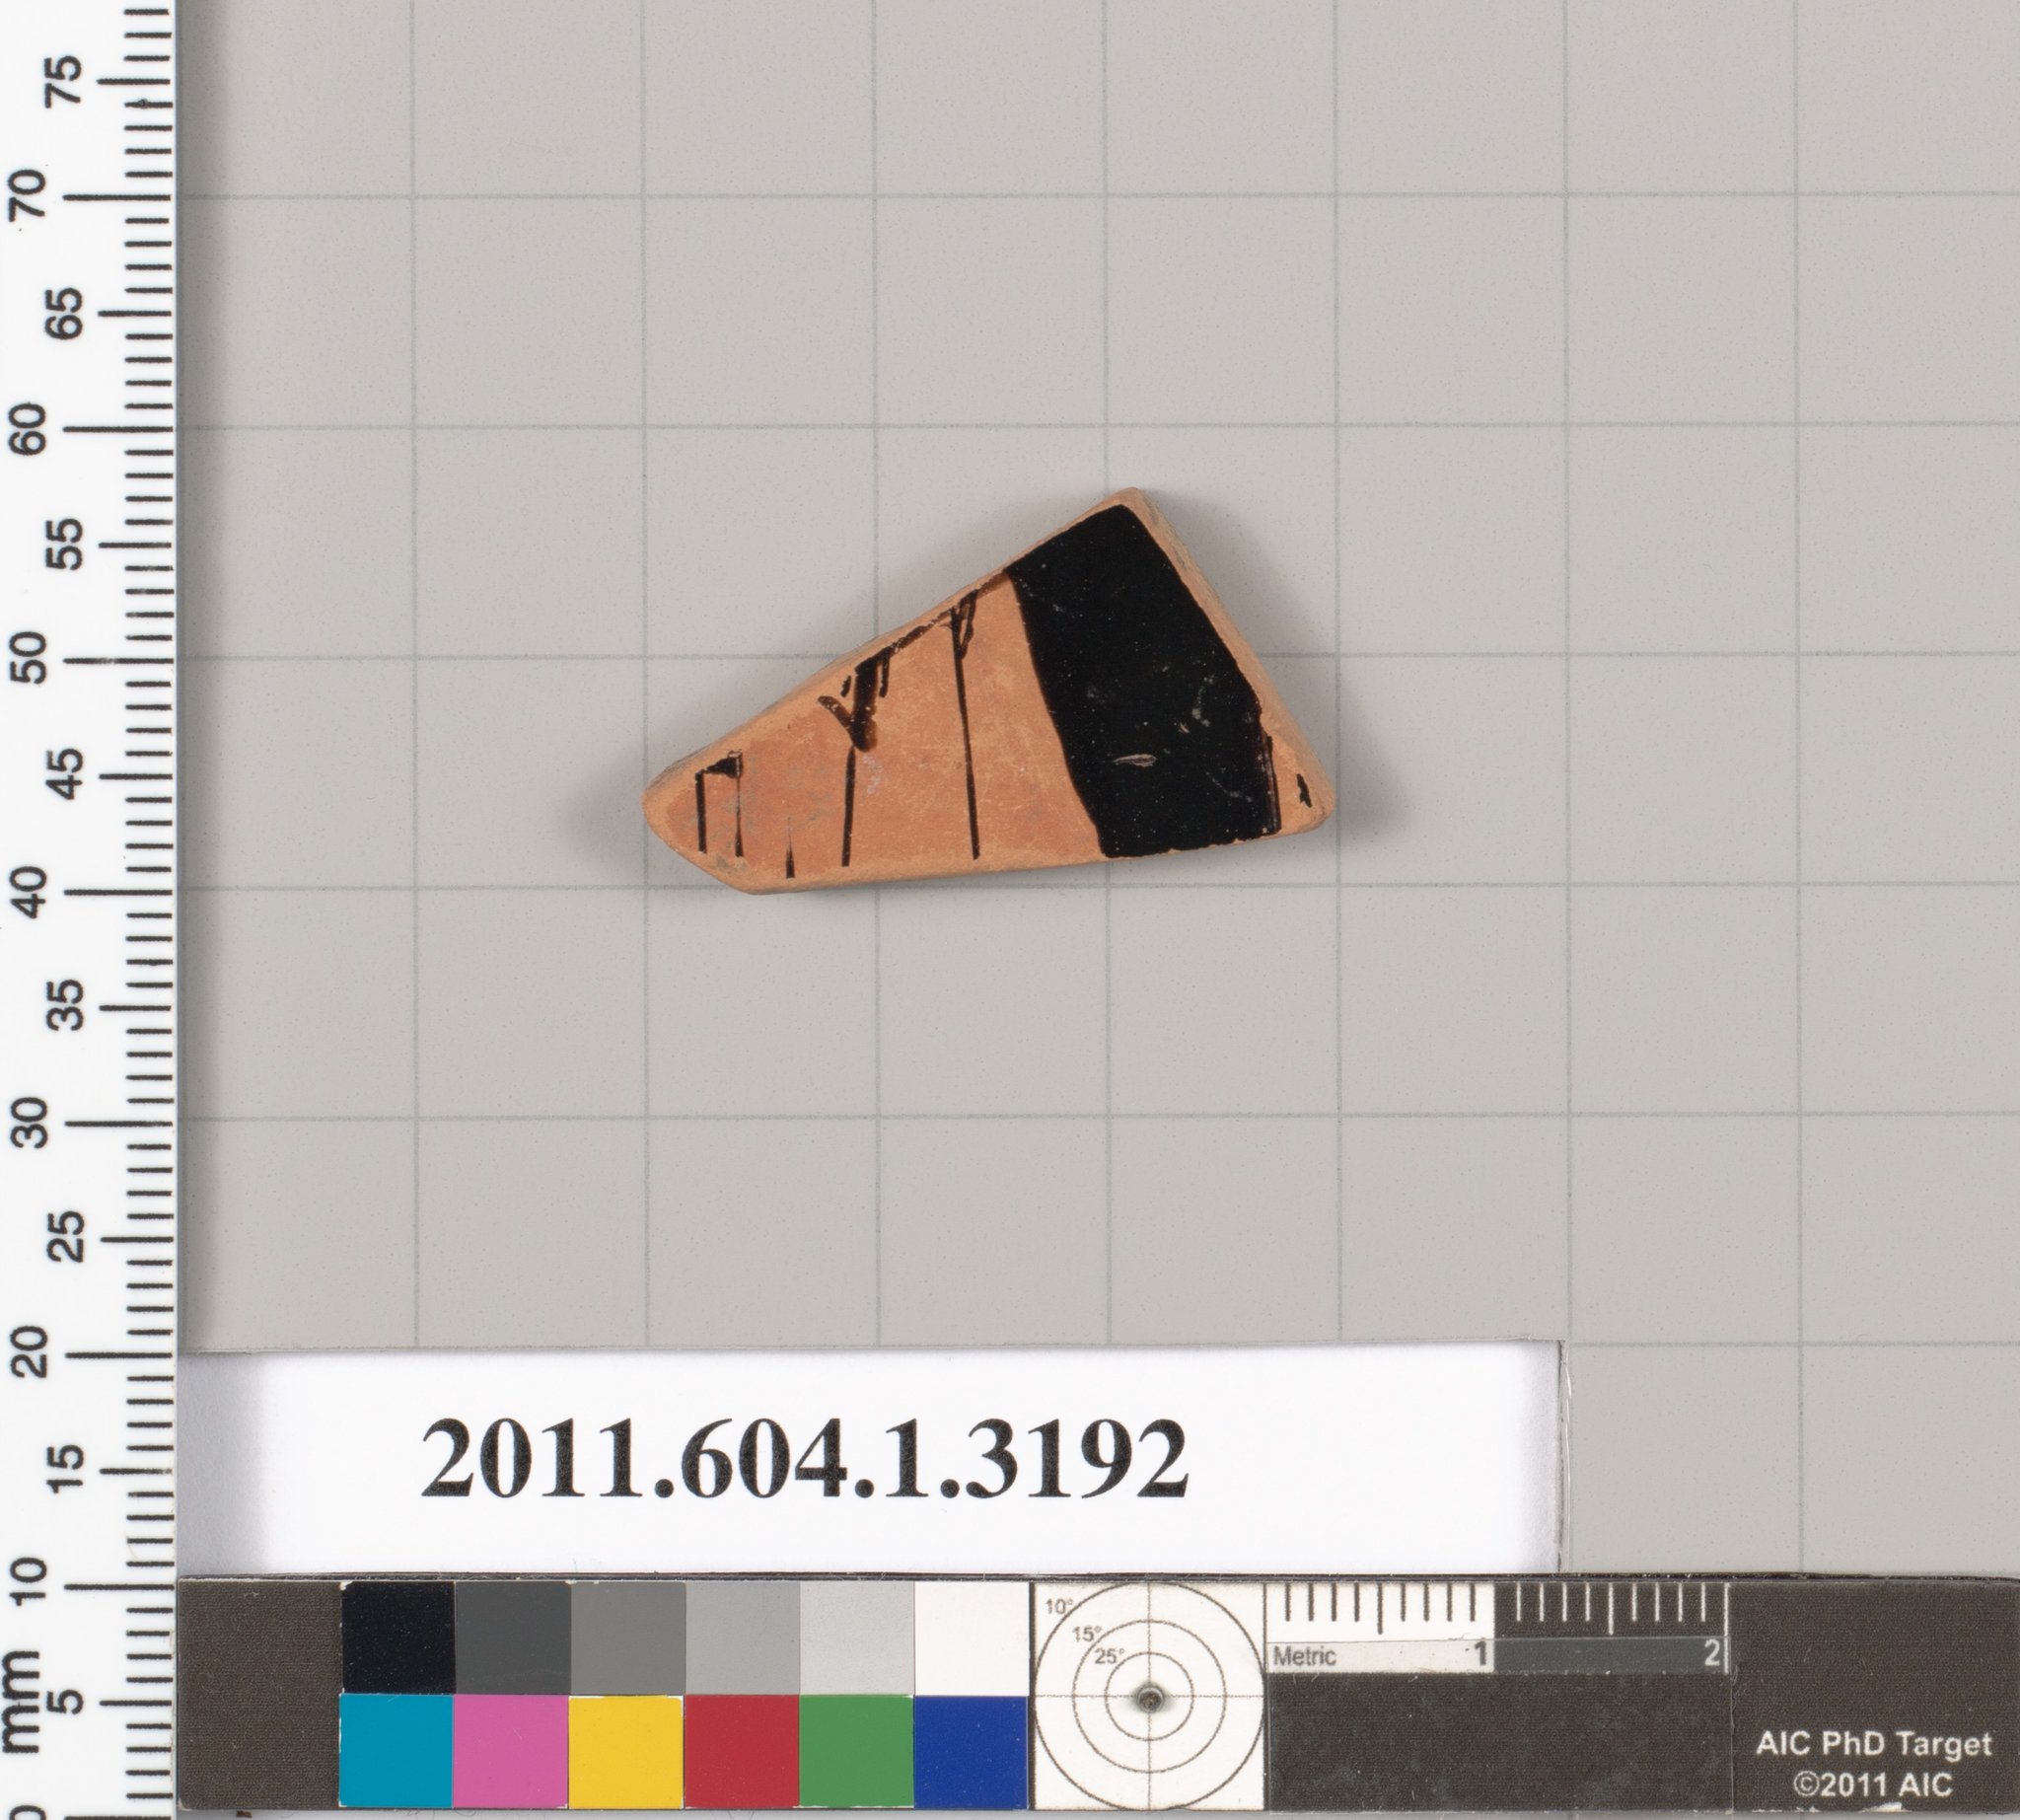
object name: kylix fragment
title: Terracotta fragment of a kylix (drinking cup)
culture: greek, attic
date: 467-435 BCE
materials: terracotta